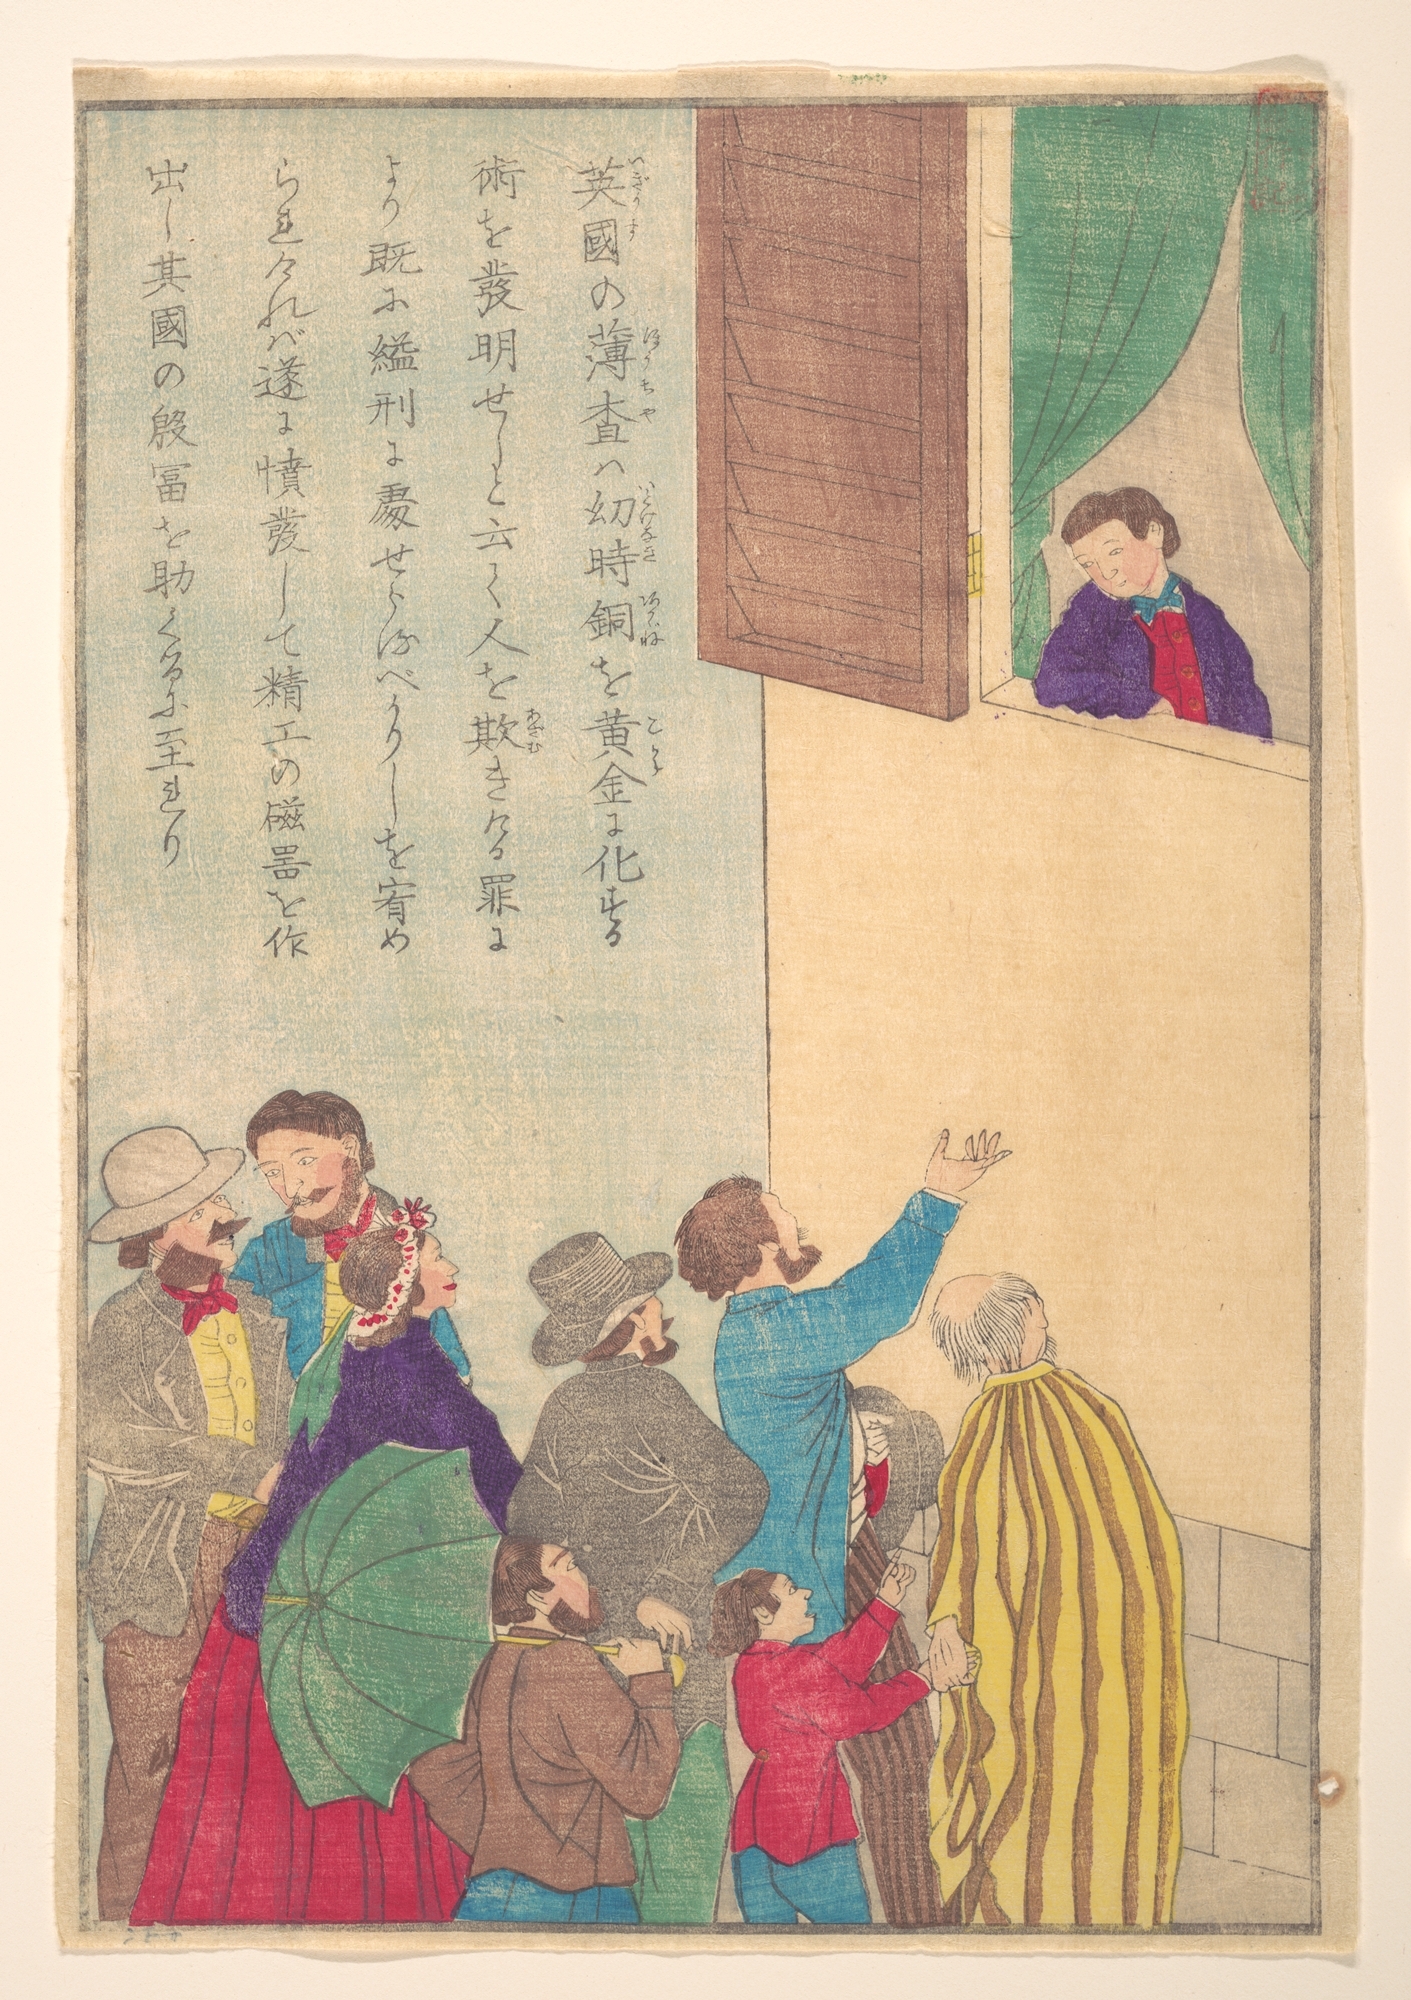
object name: print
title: Lives of Great People of the Occident (Taisei ijin den): Johann Friedrich Böttger (1682–1719)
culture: japanese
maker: unidentified artist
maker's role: artist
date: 1870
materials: ink, paper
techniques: woodblock print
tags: men,women